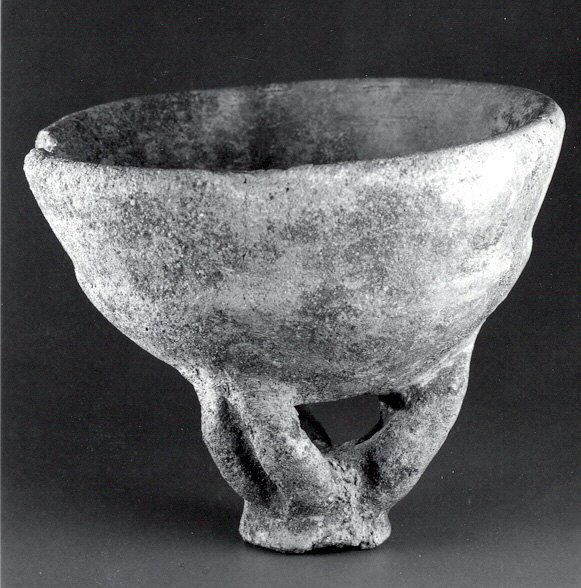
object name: vessel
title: Vessel: Footed Base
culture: dogon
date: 1701-1900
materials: terracotta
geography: mali